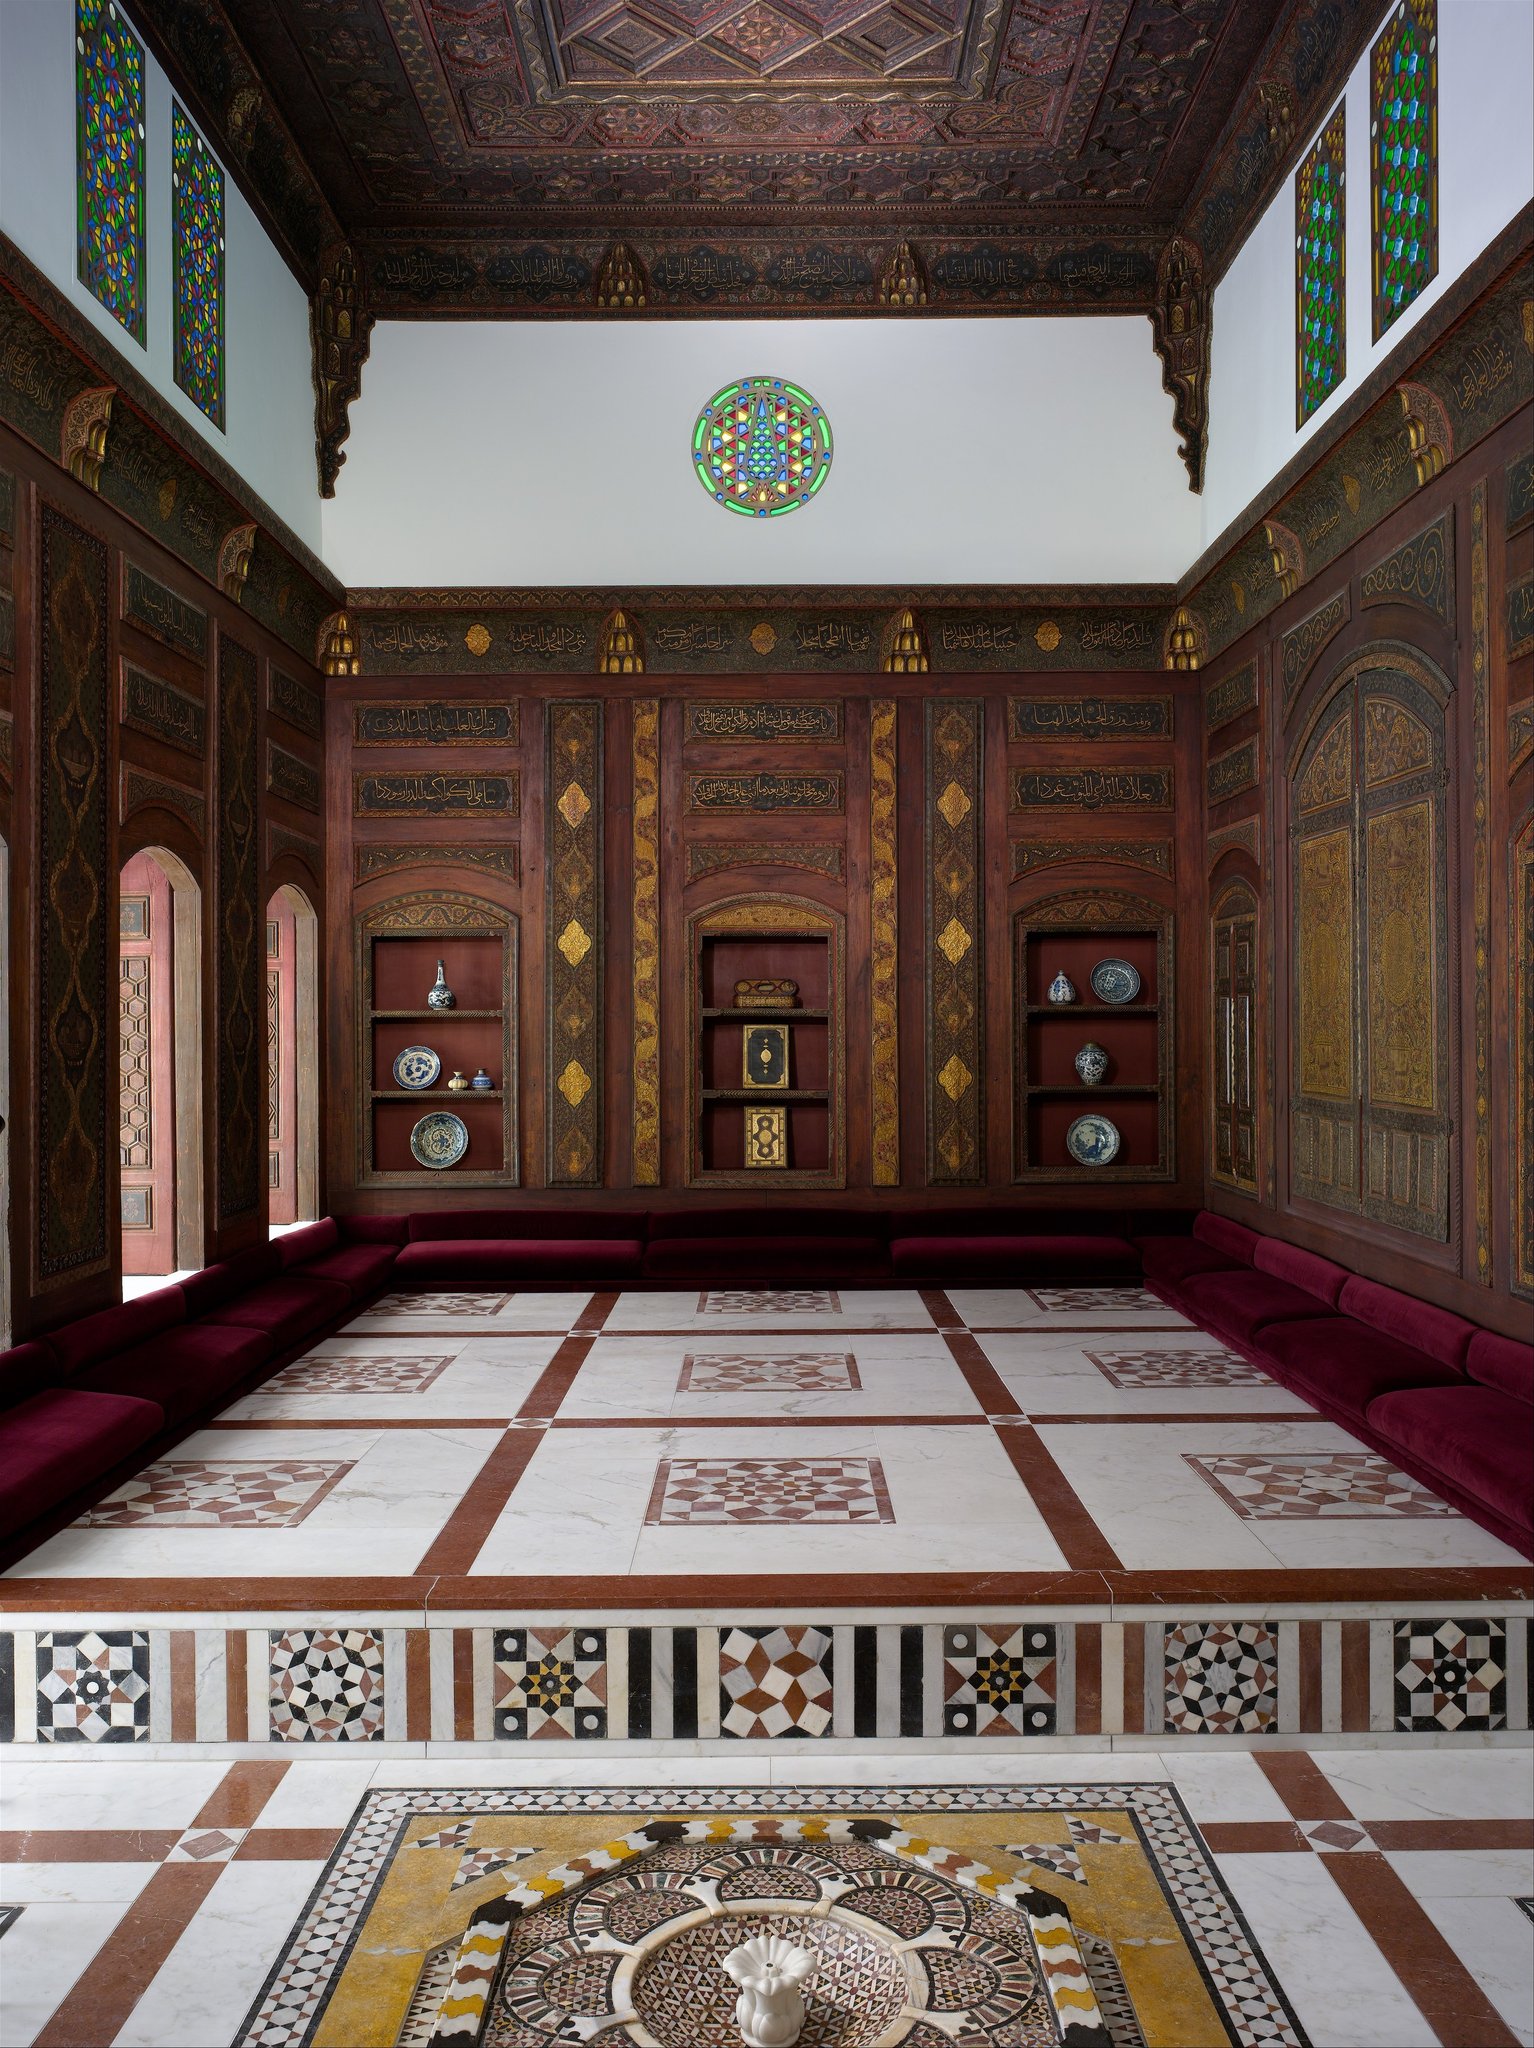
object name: period room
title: Damascus Room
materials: brass, ceramic, gesso, glass, glaze, gold, iron, marble, mother of pearl, paint, plaster, stone, tin, wood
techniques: relief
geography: syria